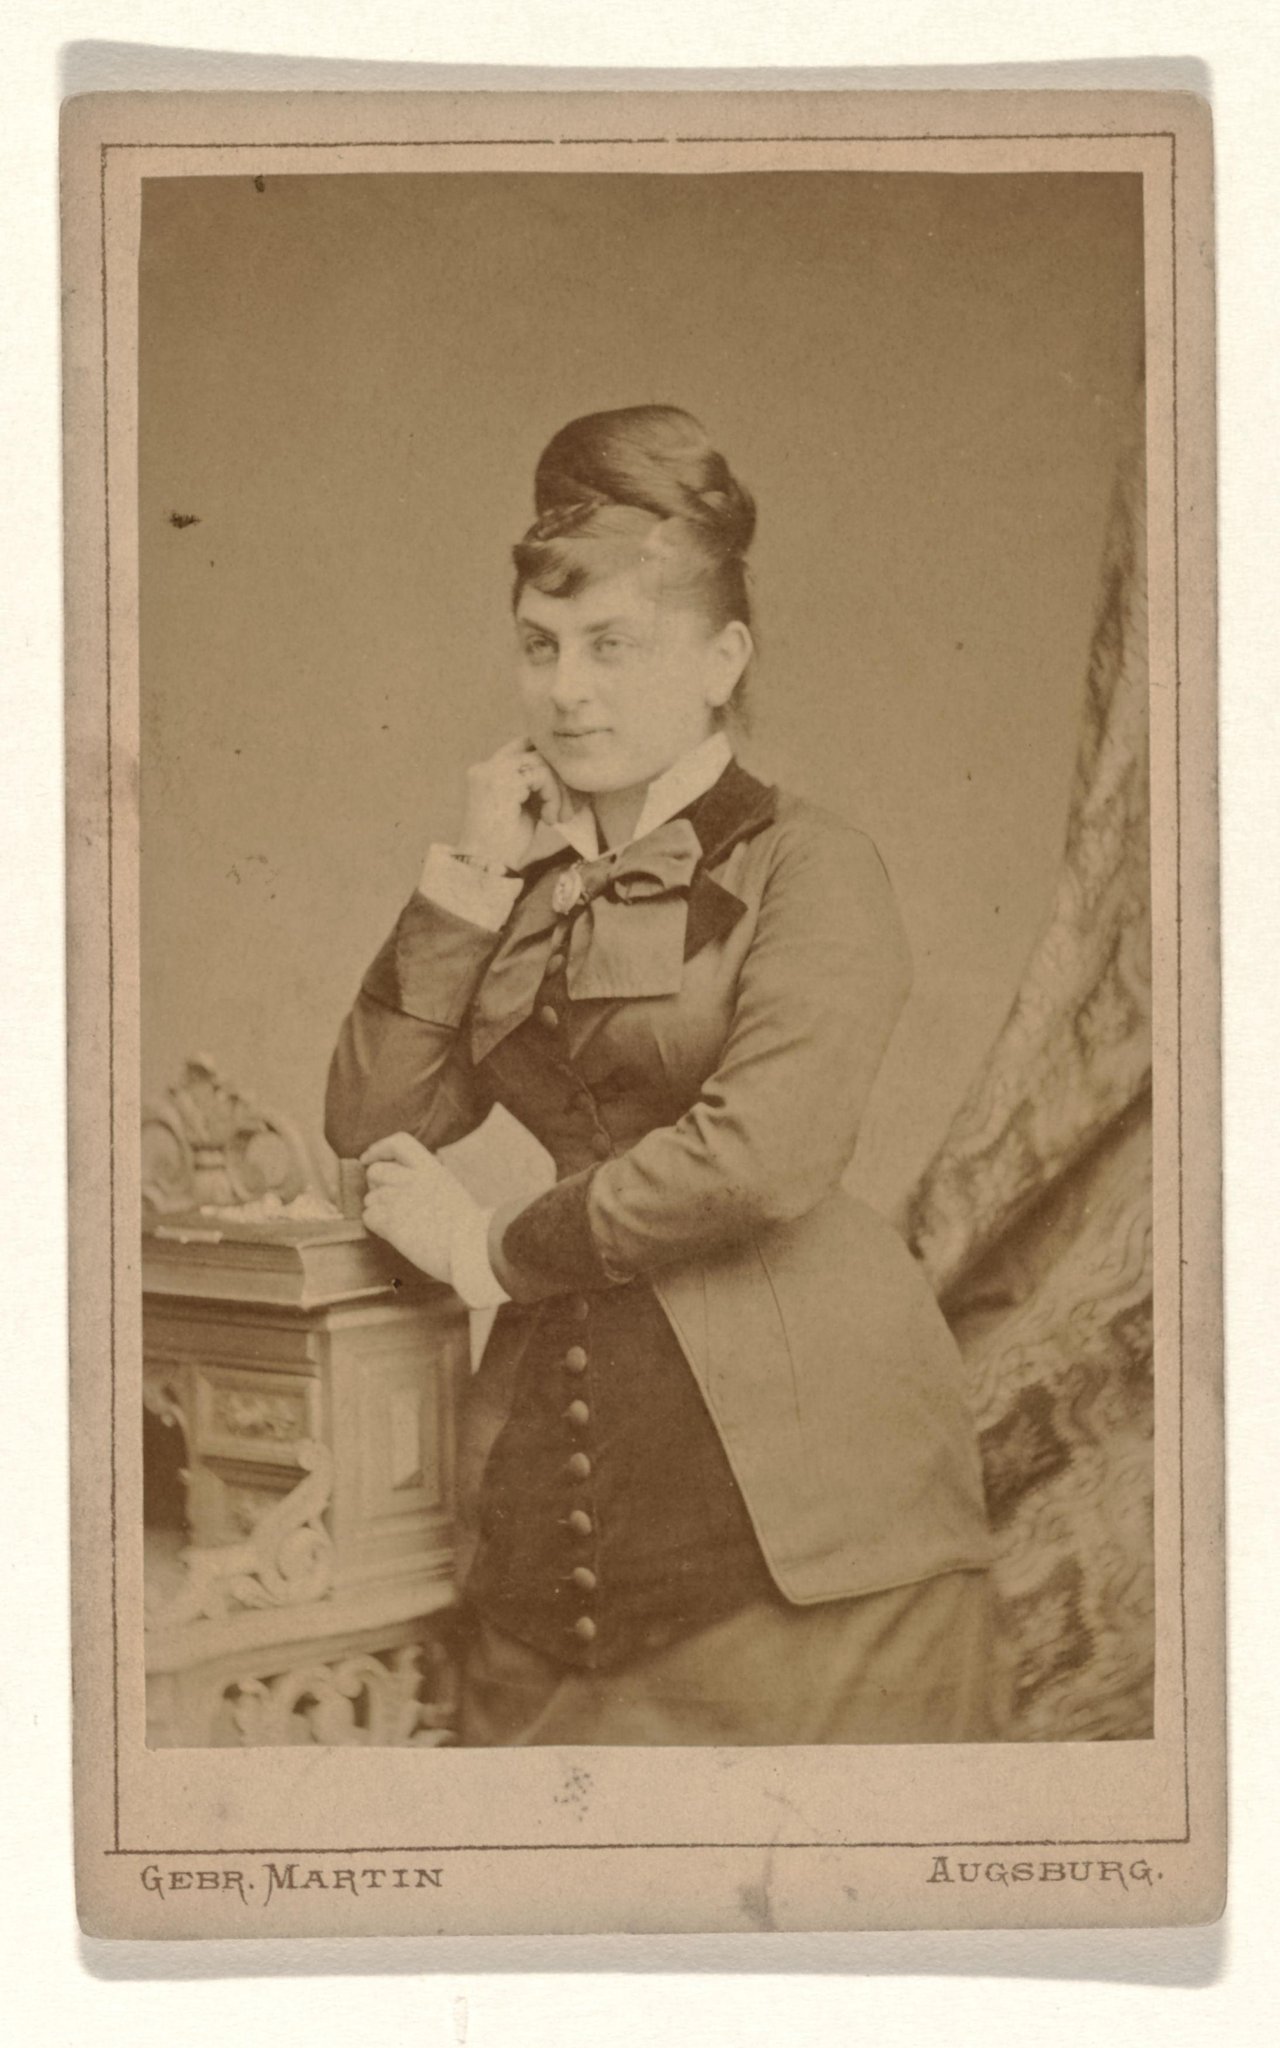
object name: photograph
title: Else Wachenheimer-Moos als jonge vrouw, met opgestoken haar en getailleerde jas en lange donkere kleding, leunend met haar elleboog op een kastje en haar andere hand steunend op dat kastje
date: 1911-1926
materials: photographic support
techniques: gelatin silver print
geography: augsburg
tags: else wachenheimer-moos, augsburg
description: Else Wachenheimer-Moos als jonge vrouw, met opgestoken haar en getailleerde jas en lange donkere kleding, leunend met haar elleboog op een kastje en haar andere hand steunend op dat kastje.